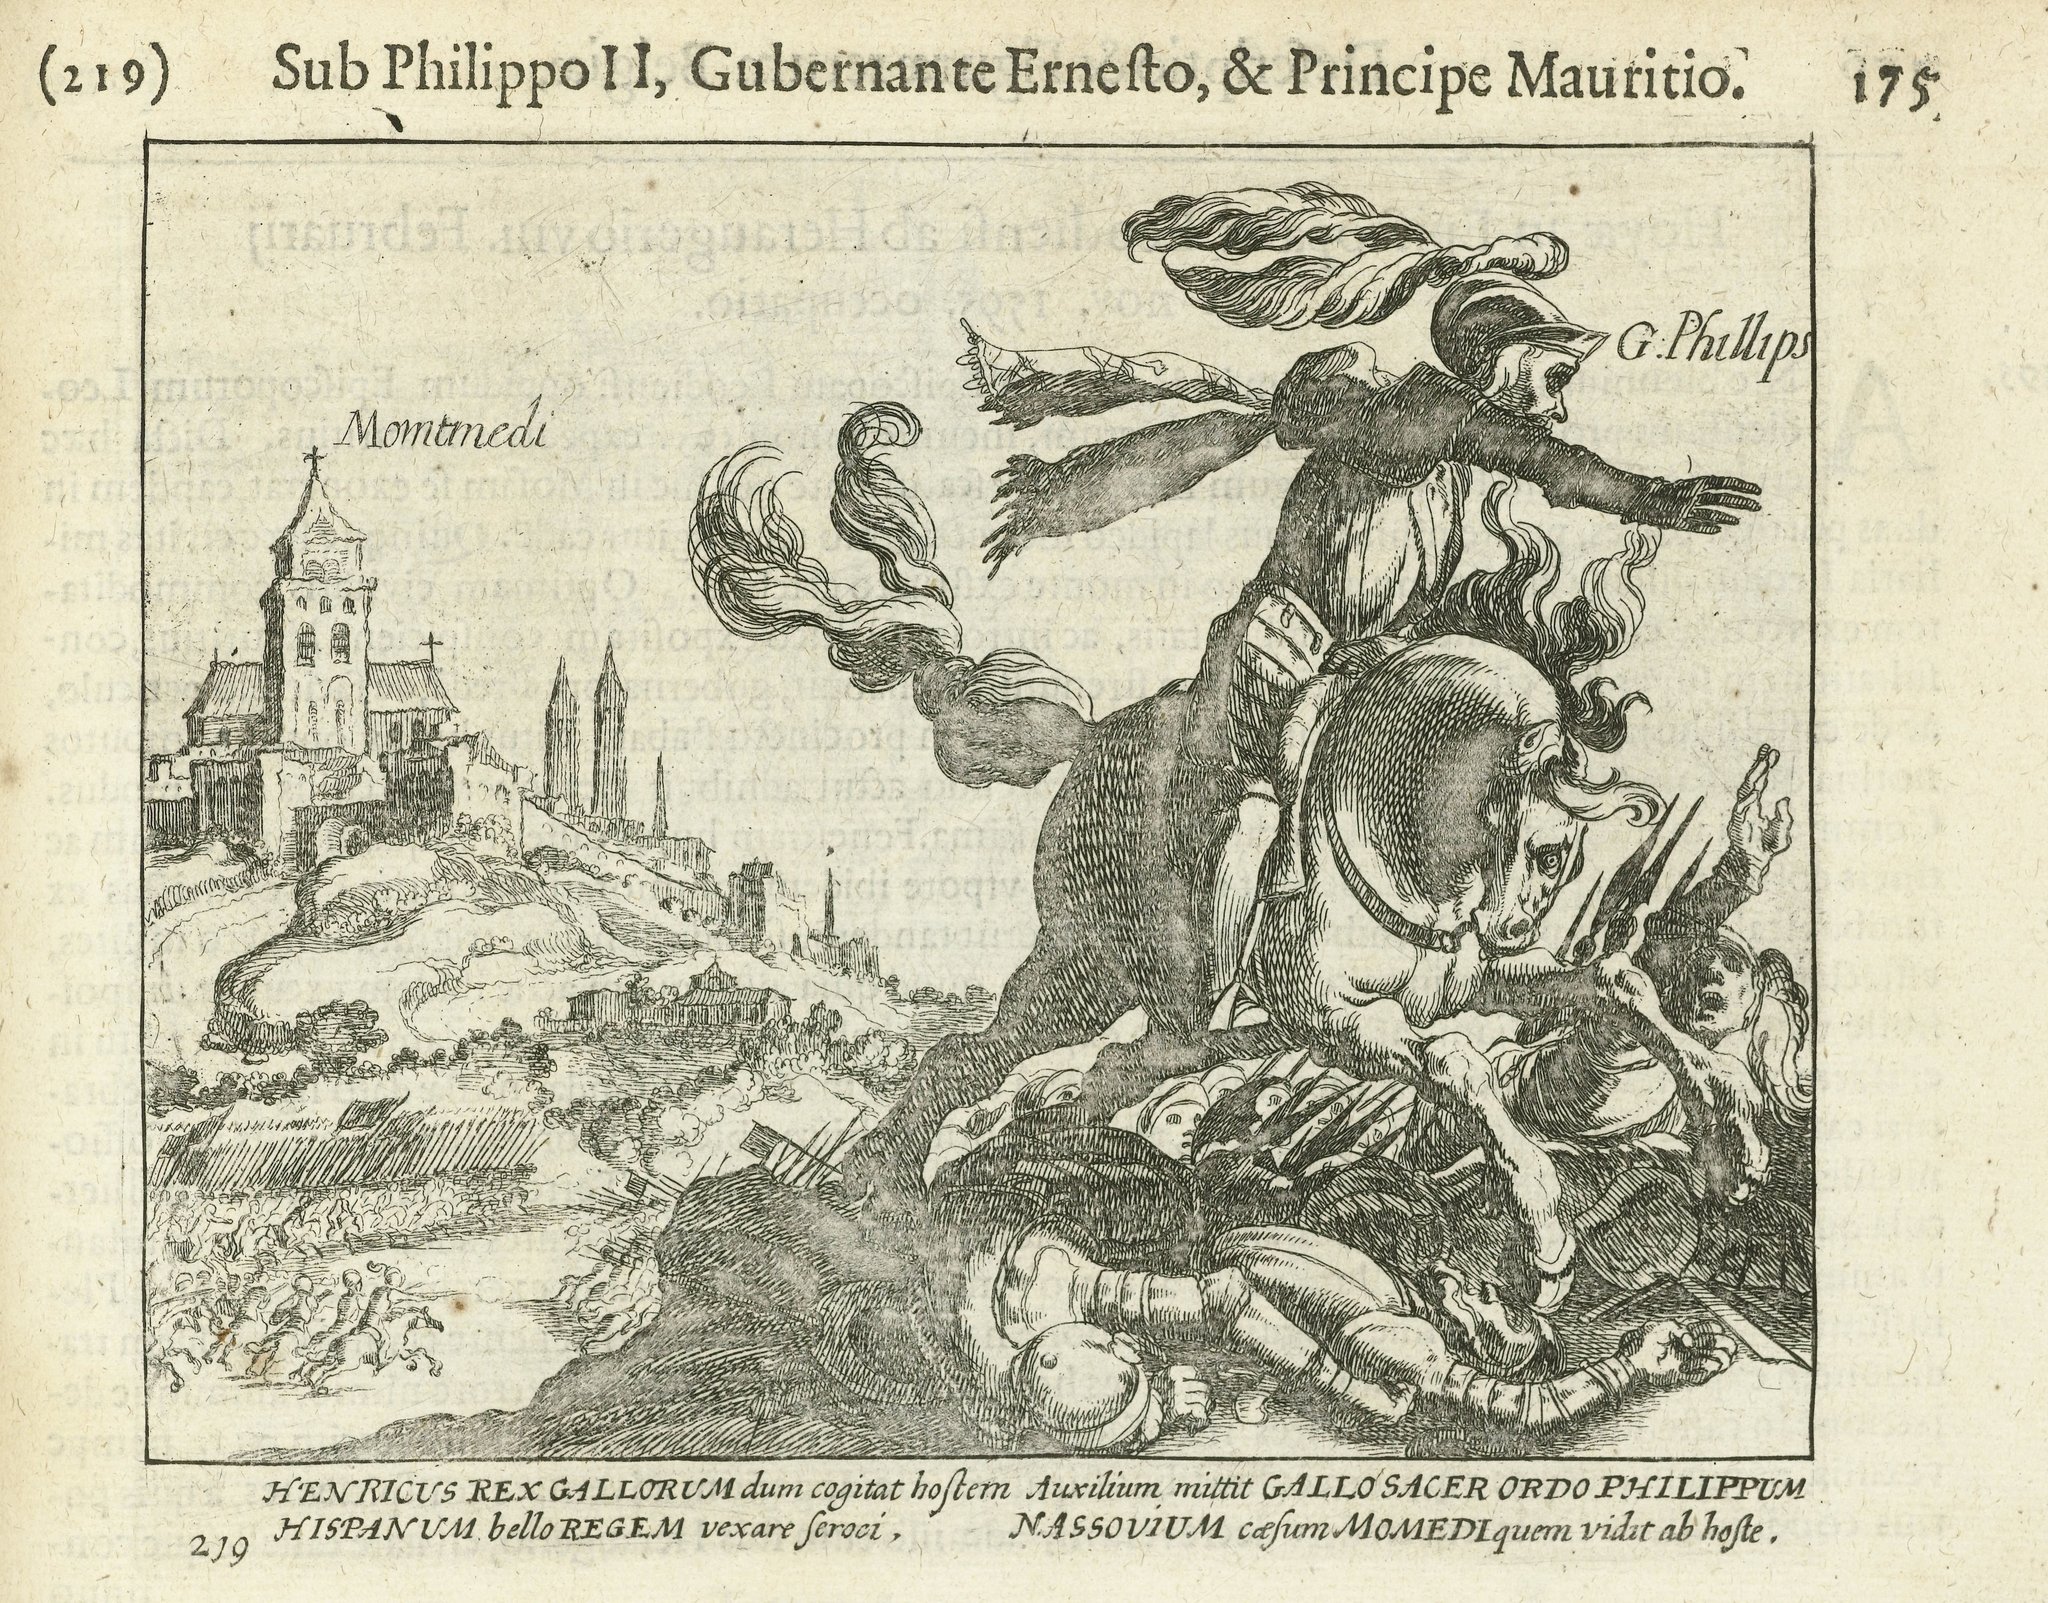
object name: print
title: Lodewijk Gunther, prins van Nassau-Siegen en Filips, graaf van Nassau vechten samen met de Franse koning Hendrik IV bij Montmédy, 1595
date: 1613-1615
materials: paper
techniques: etching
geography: amsterdam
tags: paris, hendrik iv (koning van frankrijk en navarra), battle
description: Lodewijk Gunther, prins van Nassau-Siegen en Filips, graaf van Nassau vechten samen met de Franse koning Hendrik IV bij Montmédy, 1595. Op de voorgrond graaf Filips van Nassau te paard. Met onderschrift van 4 regels in het Latijn. Genummerd 219. Bedrukt op achterzijde met tekst in het Latijn.